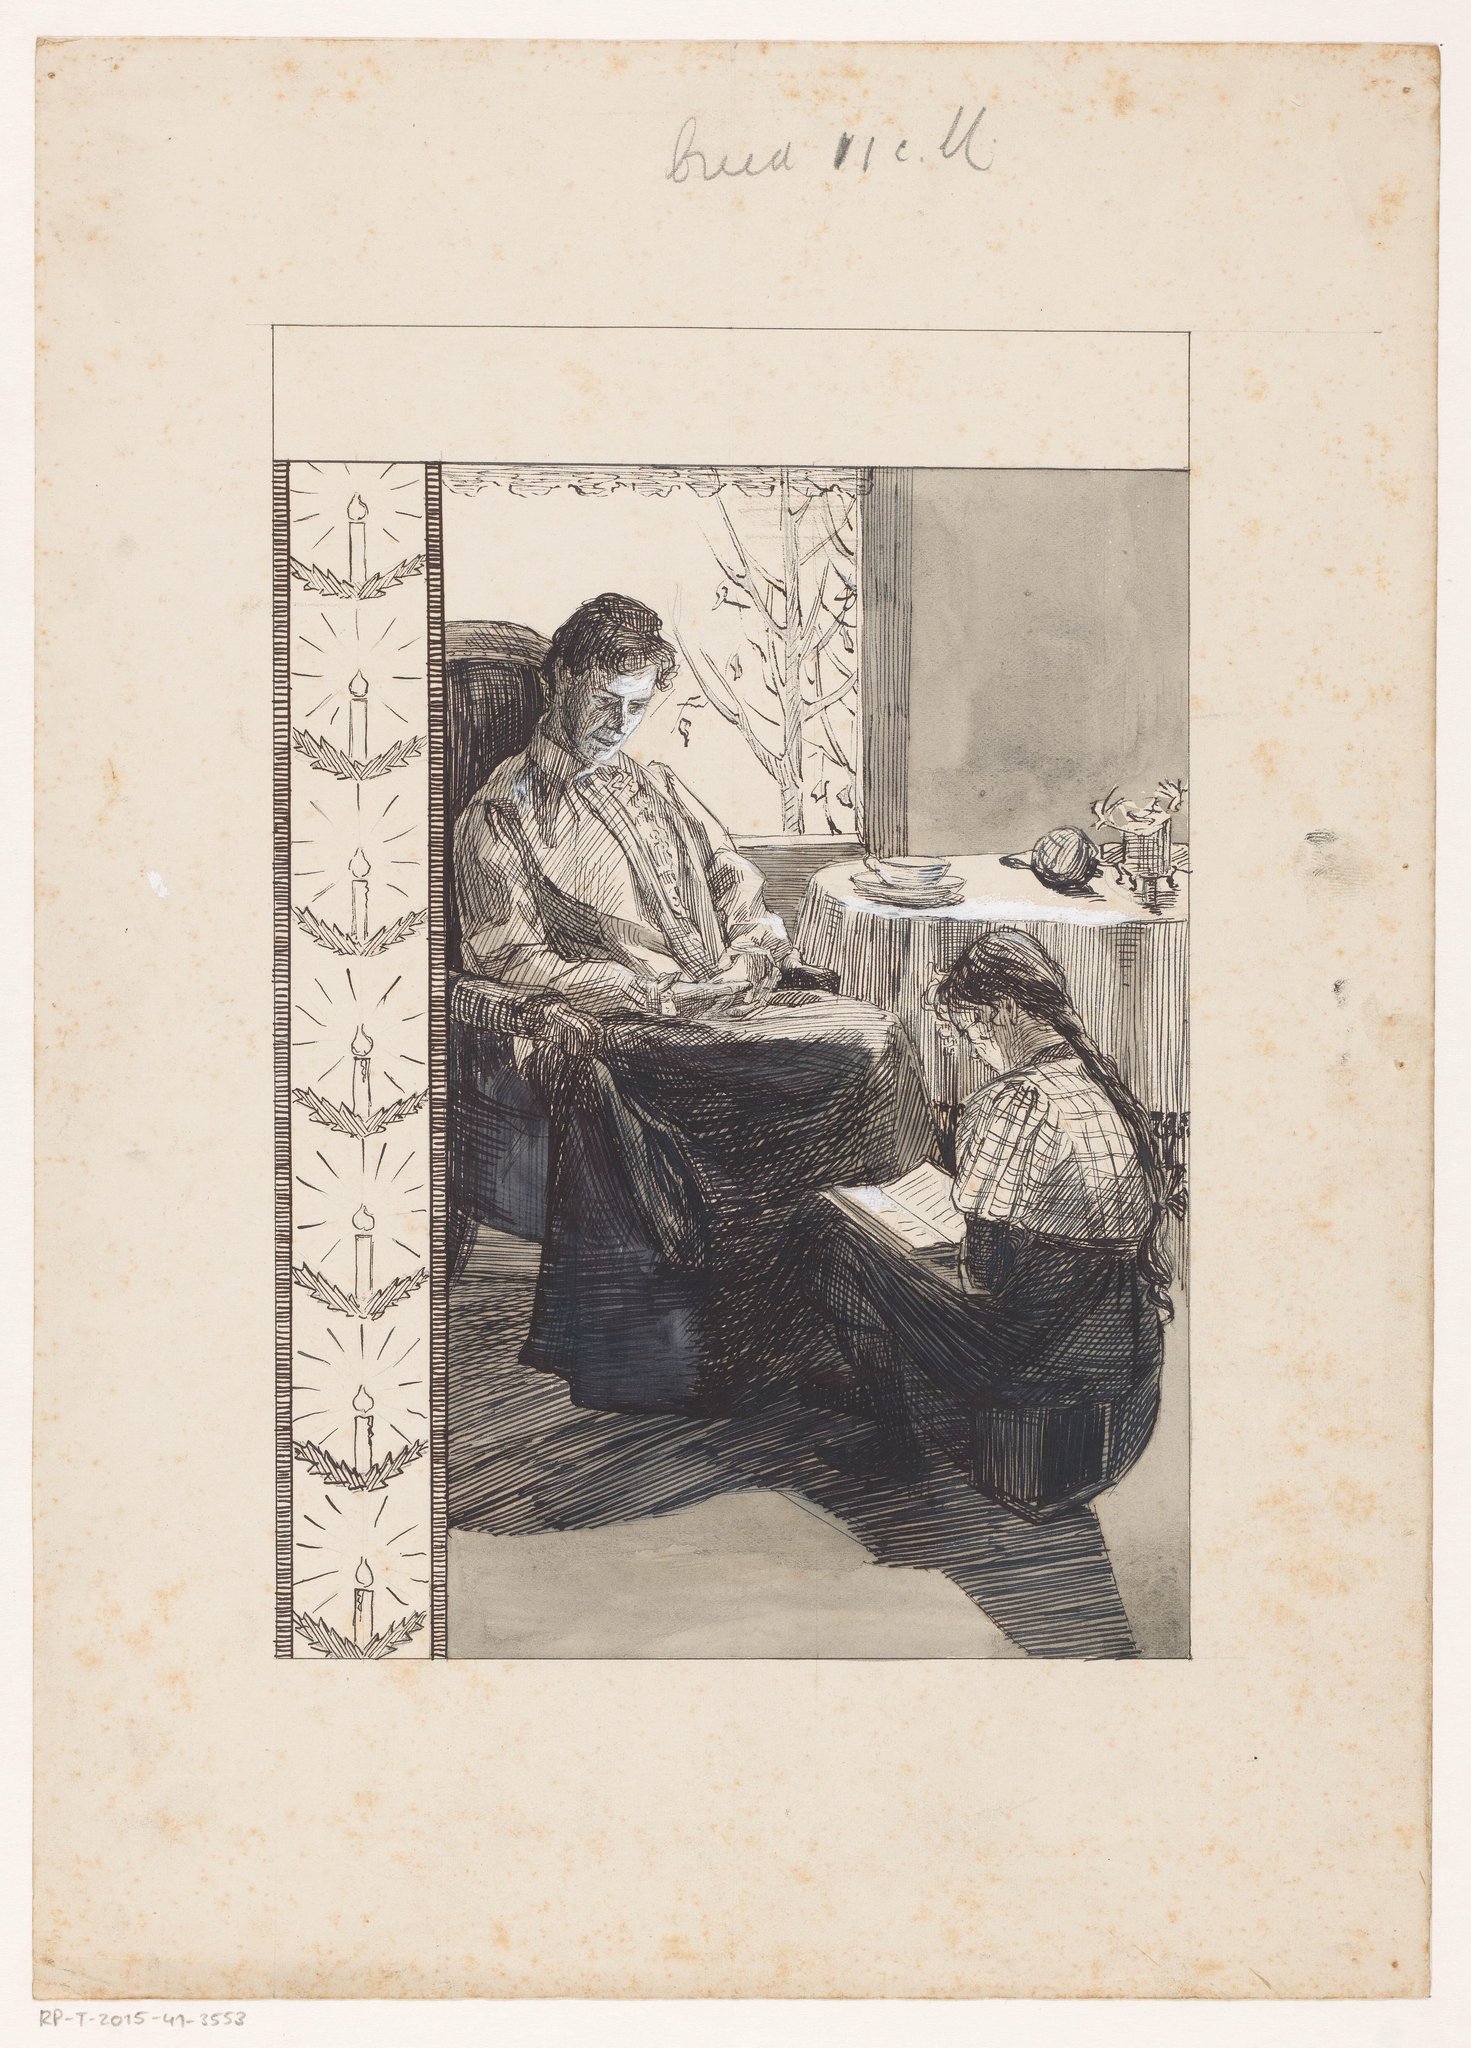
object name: drawing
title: Lezend meisje bij een zittende vrouw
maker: Anonymous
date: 1880-1930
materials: paint, ink, paper, pencil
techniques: brush, pen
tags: armchair, seat, reading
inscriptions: collector's mark: Lugt 2228a, :, annotation: ‘"Lize"’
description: In een zitkamer zit een meisje op de grond te lezen aan de voeten van een vrouw die in een leunstoel zit. Door het venster is een boom met grotendeels kale takken te zien. Links een sierrand met brandende kaarsen en dennentakken.